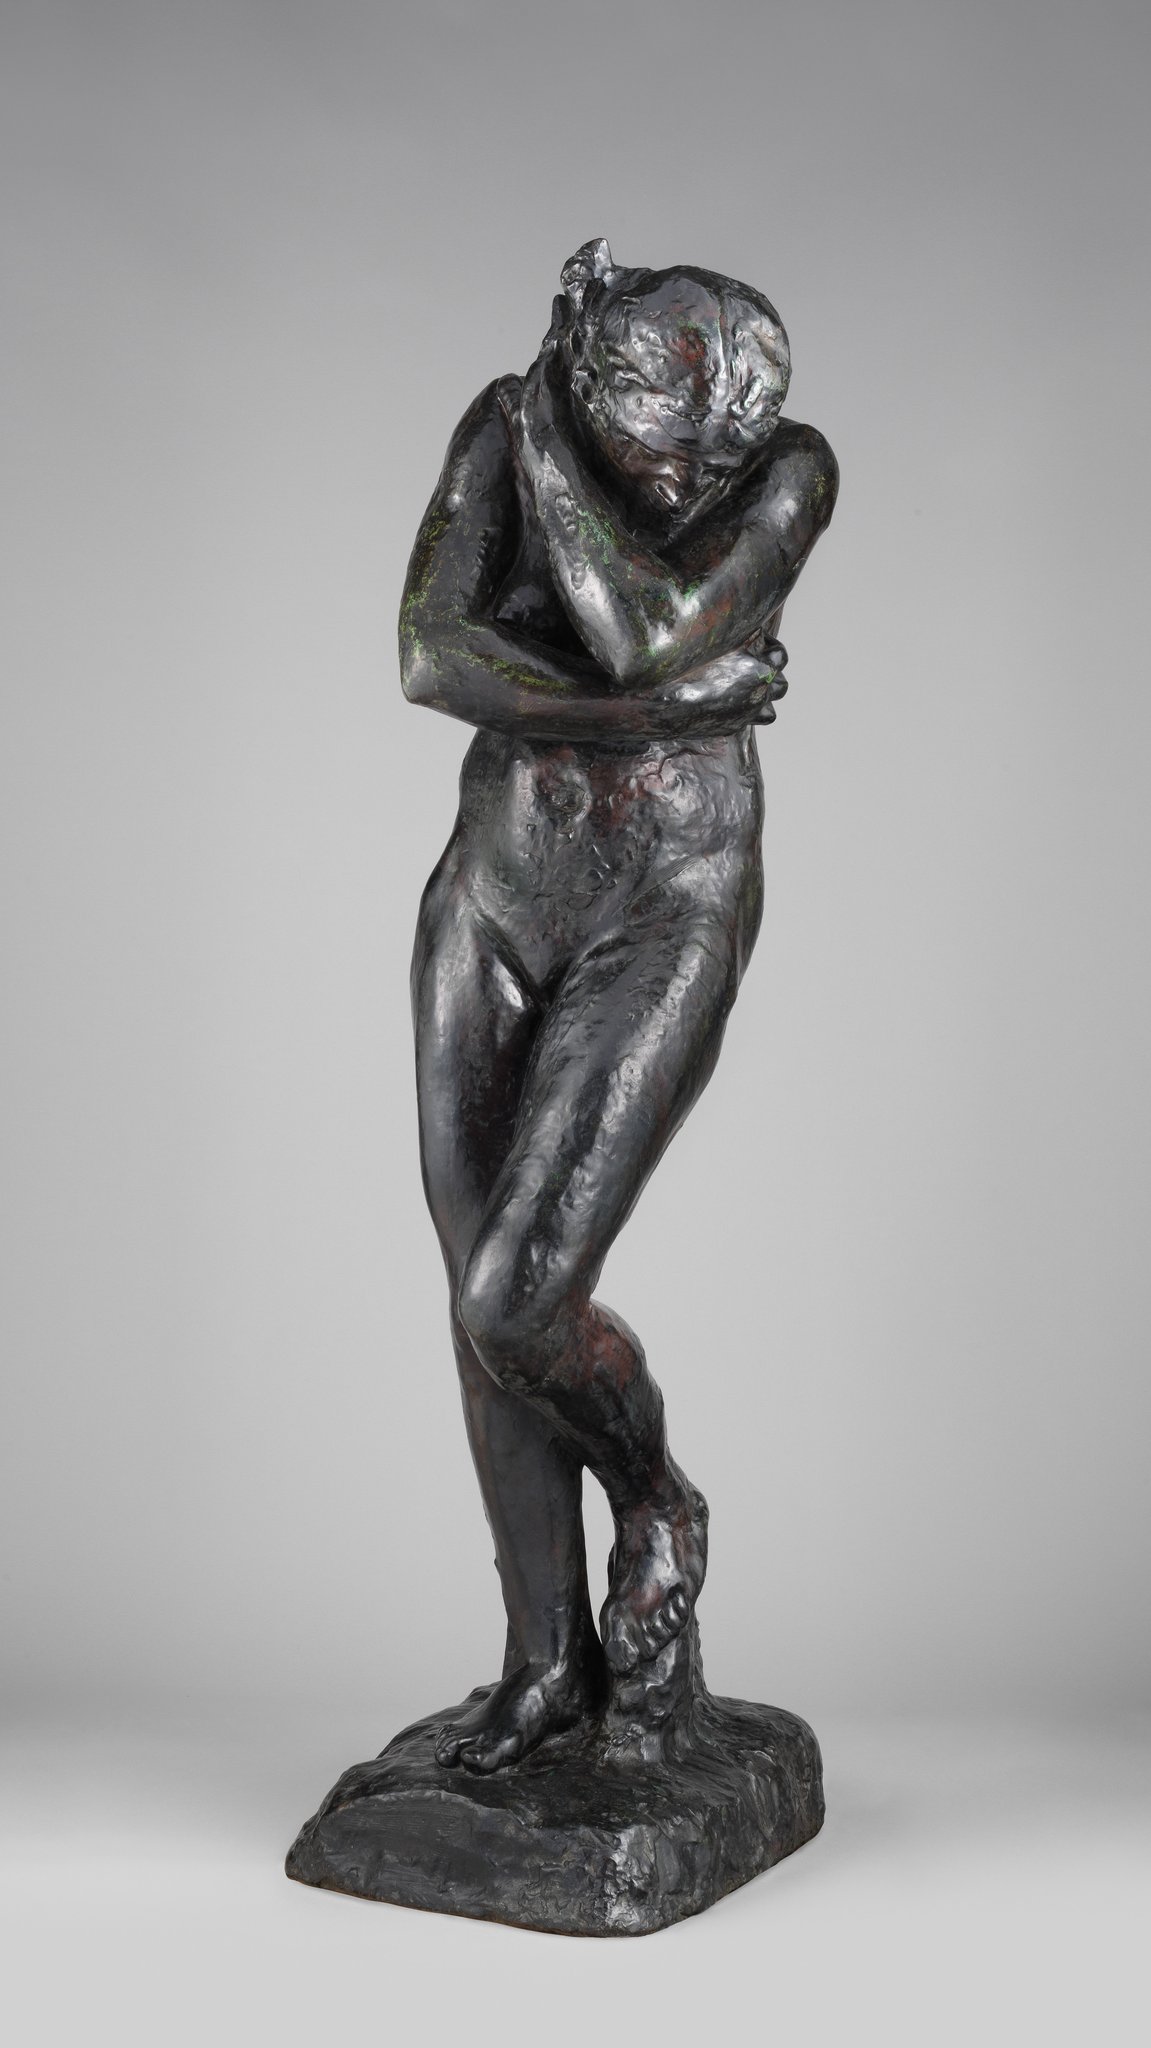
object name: statue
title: Eve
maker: auguste rodin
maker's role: artist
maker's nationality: french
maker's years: 1840-1917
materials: bronze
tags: suffering,eve